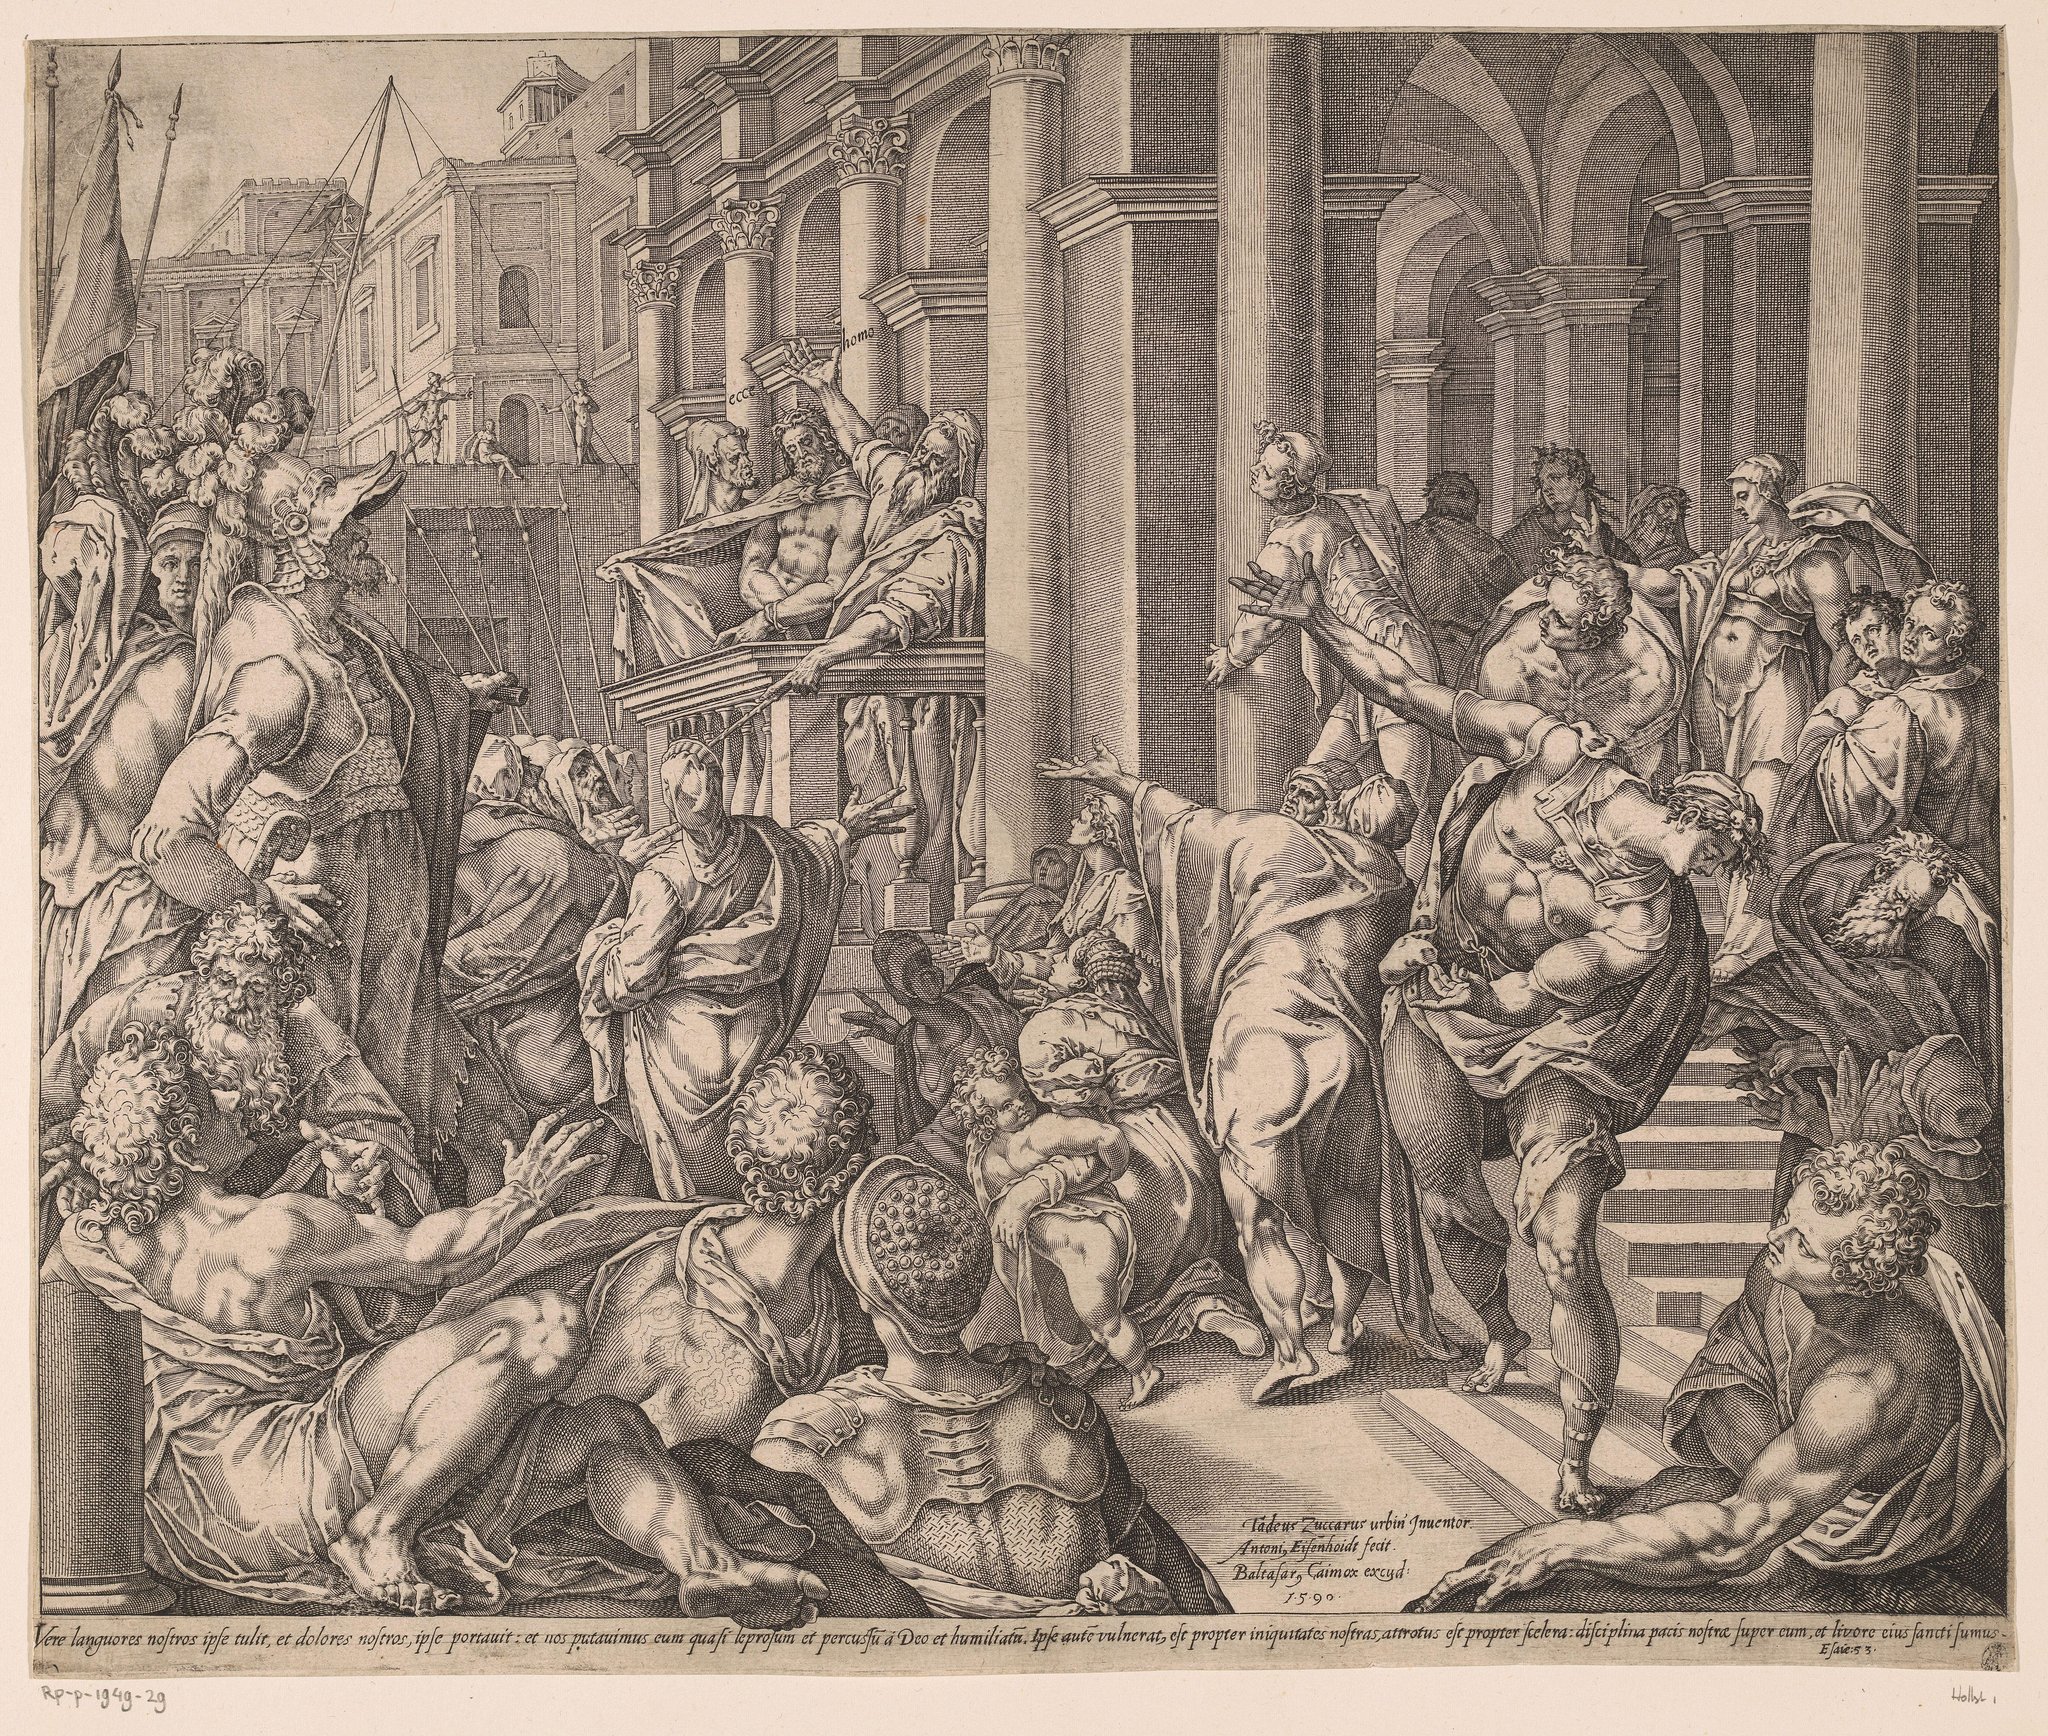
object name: print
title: Ecce homo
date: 1590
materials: paper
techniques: engraving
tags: pilate showing christ to the people, 'ostentatio christi', 'ecce homo' (john 19:4-6)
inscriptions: collector's mark: Lugt 2228, collector's mark: Lugt 971